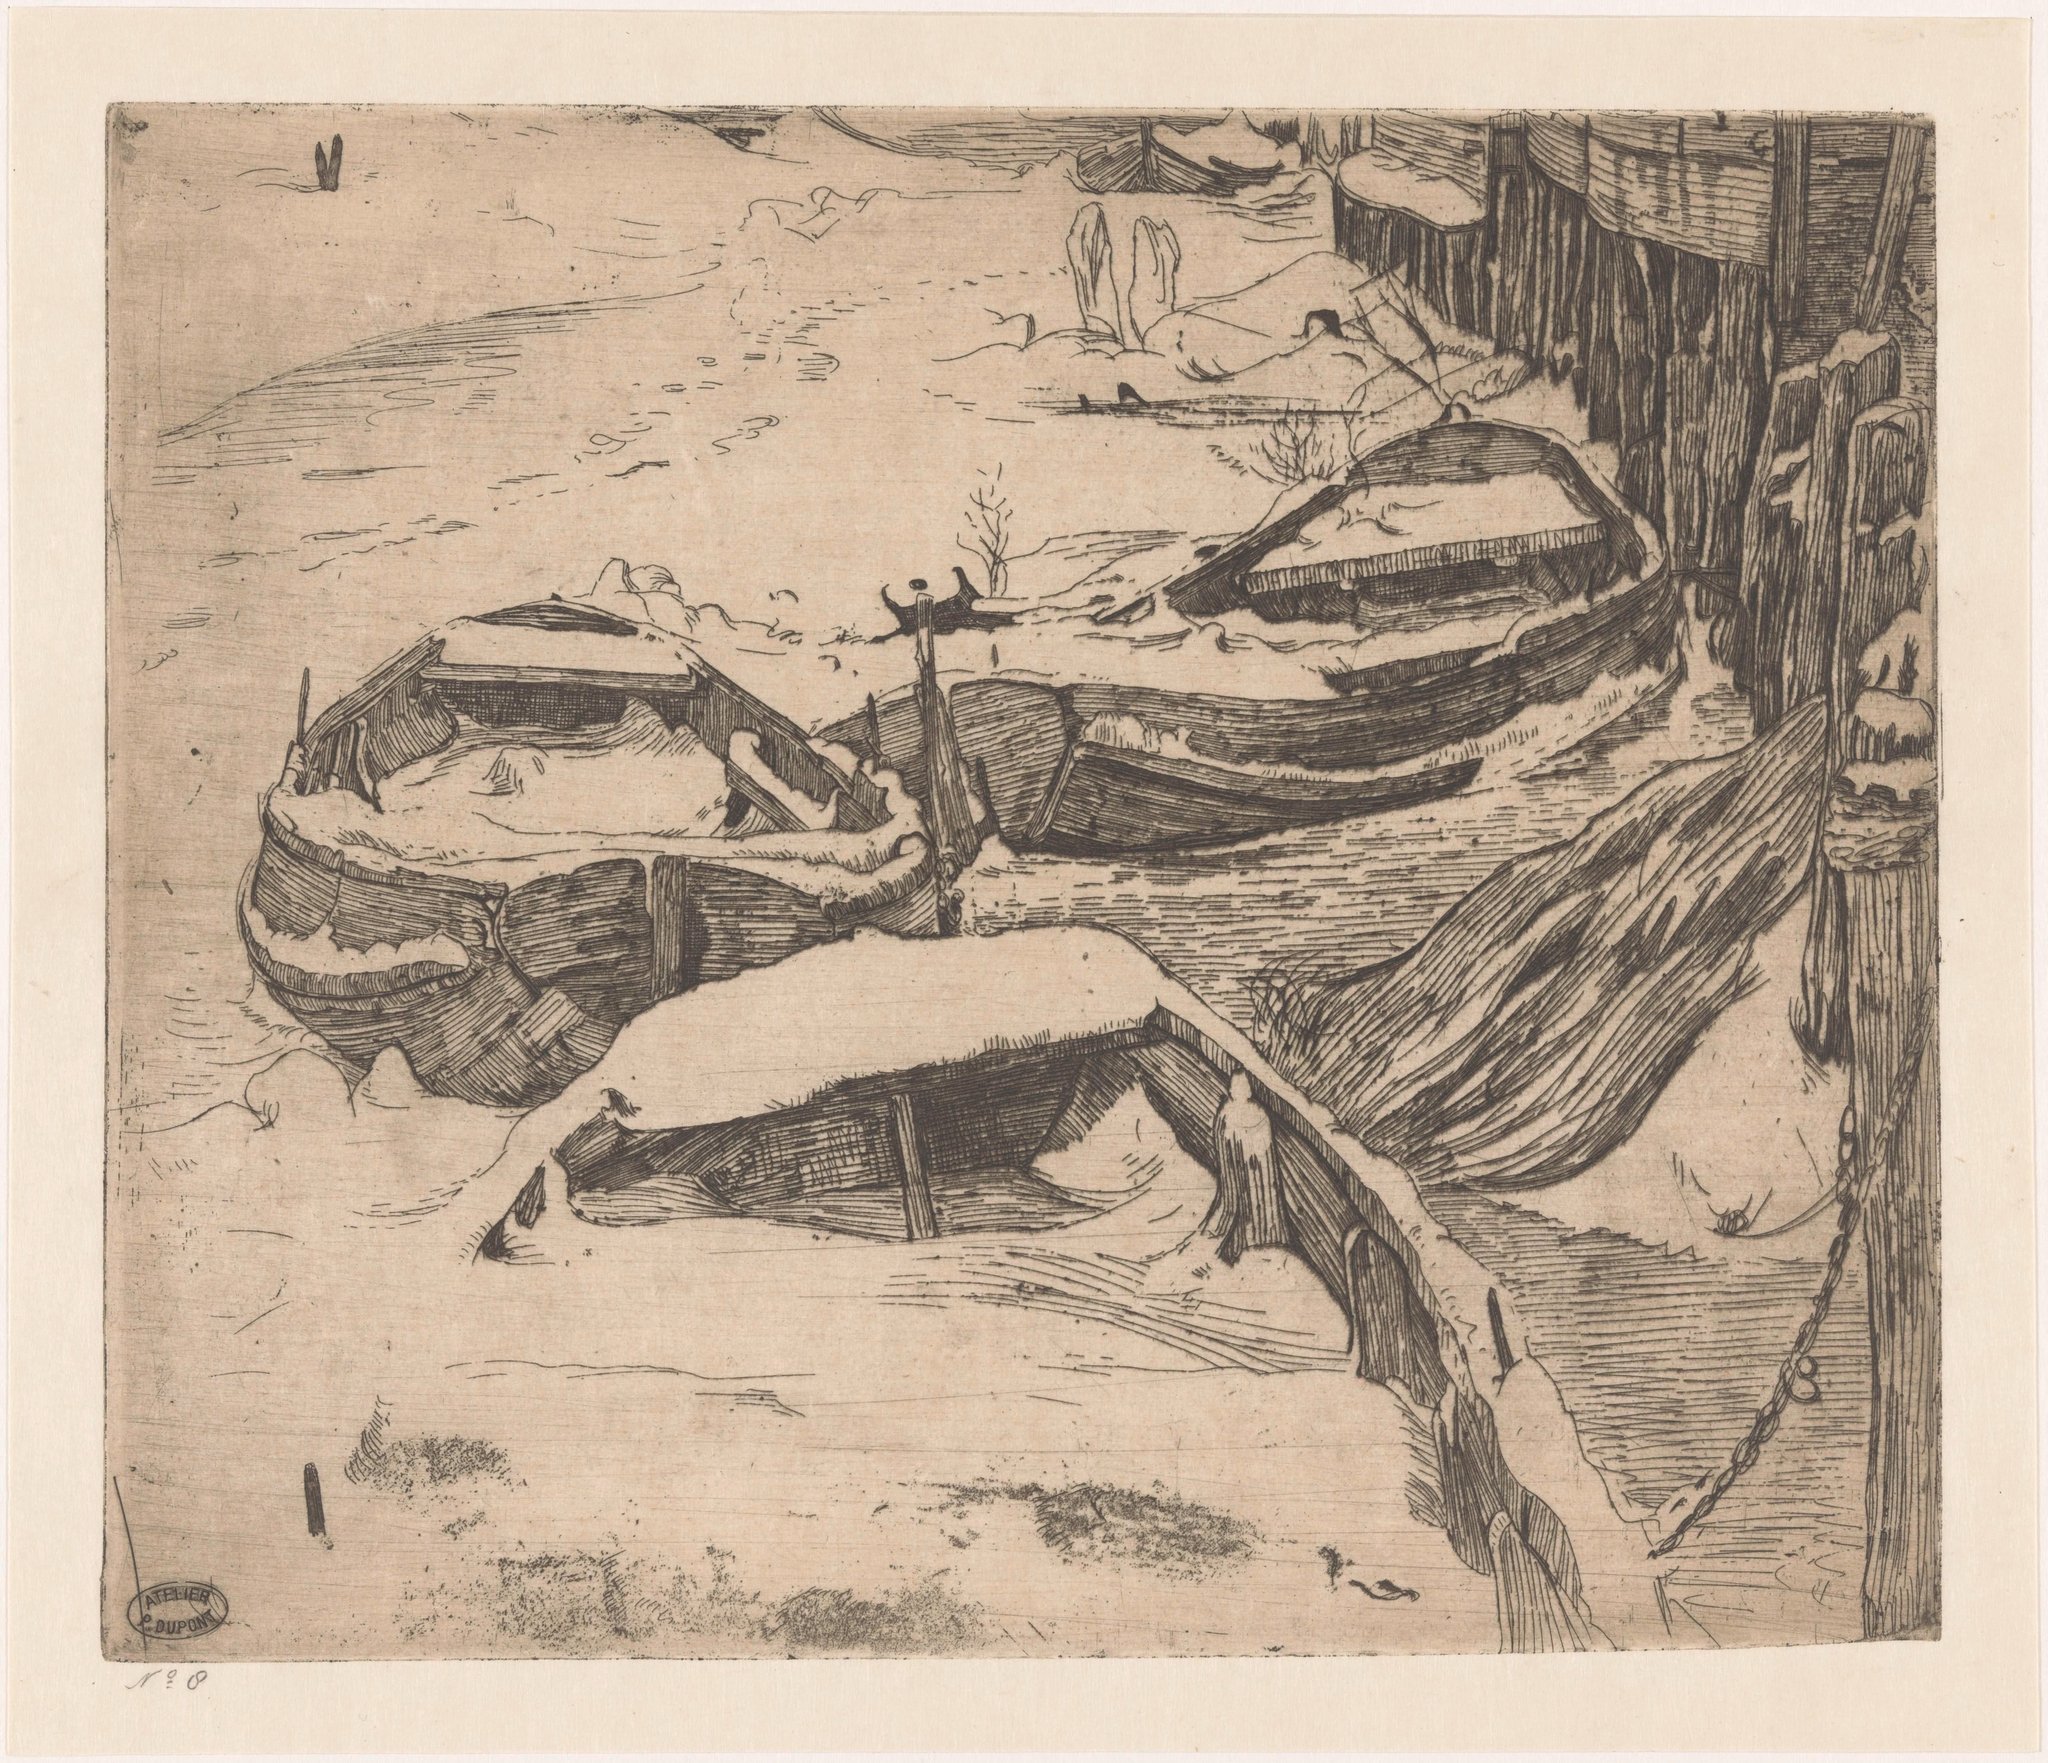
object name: print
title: Drie besneeuwde roeiboten bij een wal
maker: pieter dupont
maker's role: draughtsman, print maker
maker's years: 1870-1911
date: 1801-1895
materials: paper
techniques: intaglio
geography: amsterdam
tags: rowing-boat, canoe, etc., snow, ice ~ state of water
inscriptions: collector's mark: Lugt 2228, collector's mark: Lugt 2233, number: ‘8’, workshop stamp: ‘ATELIER P. DUPONT’